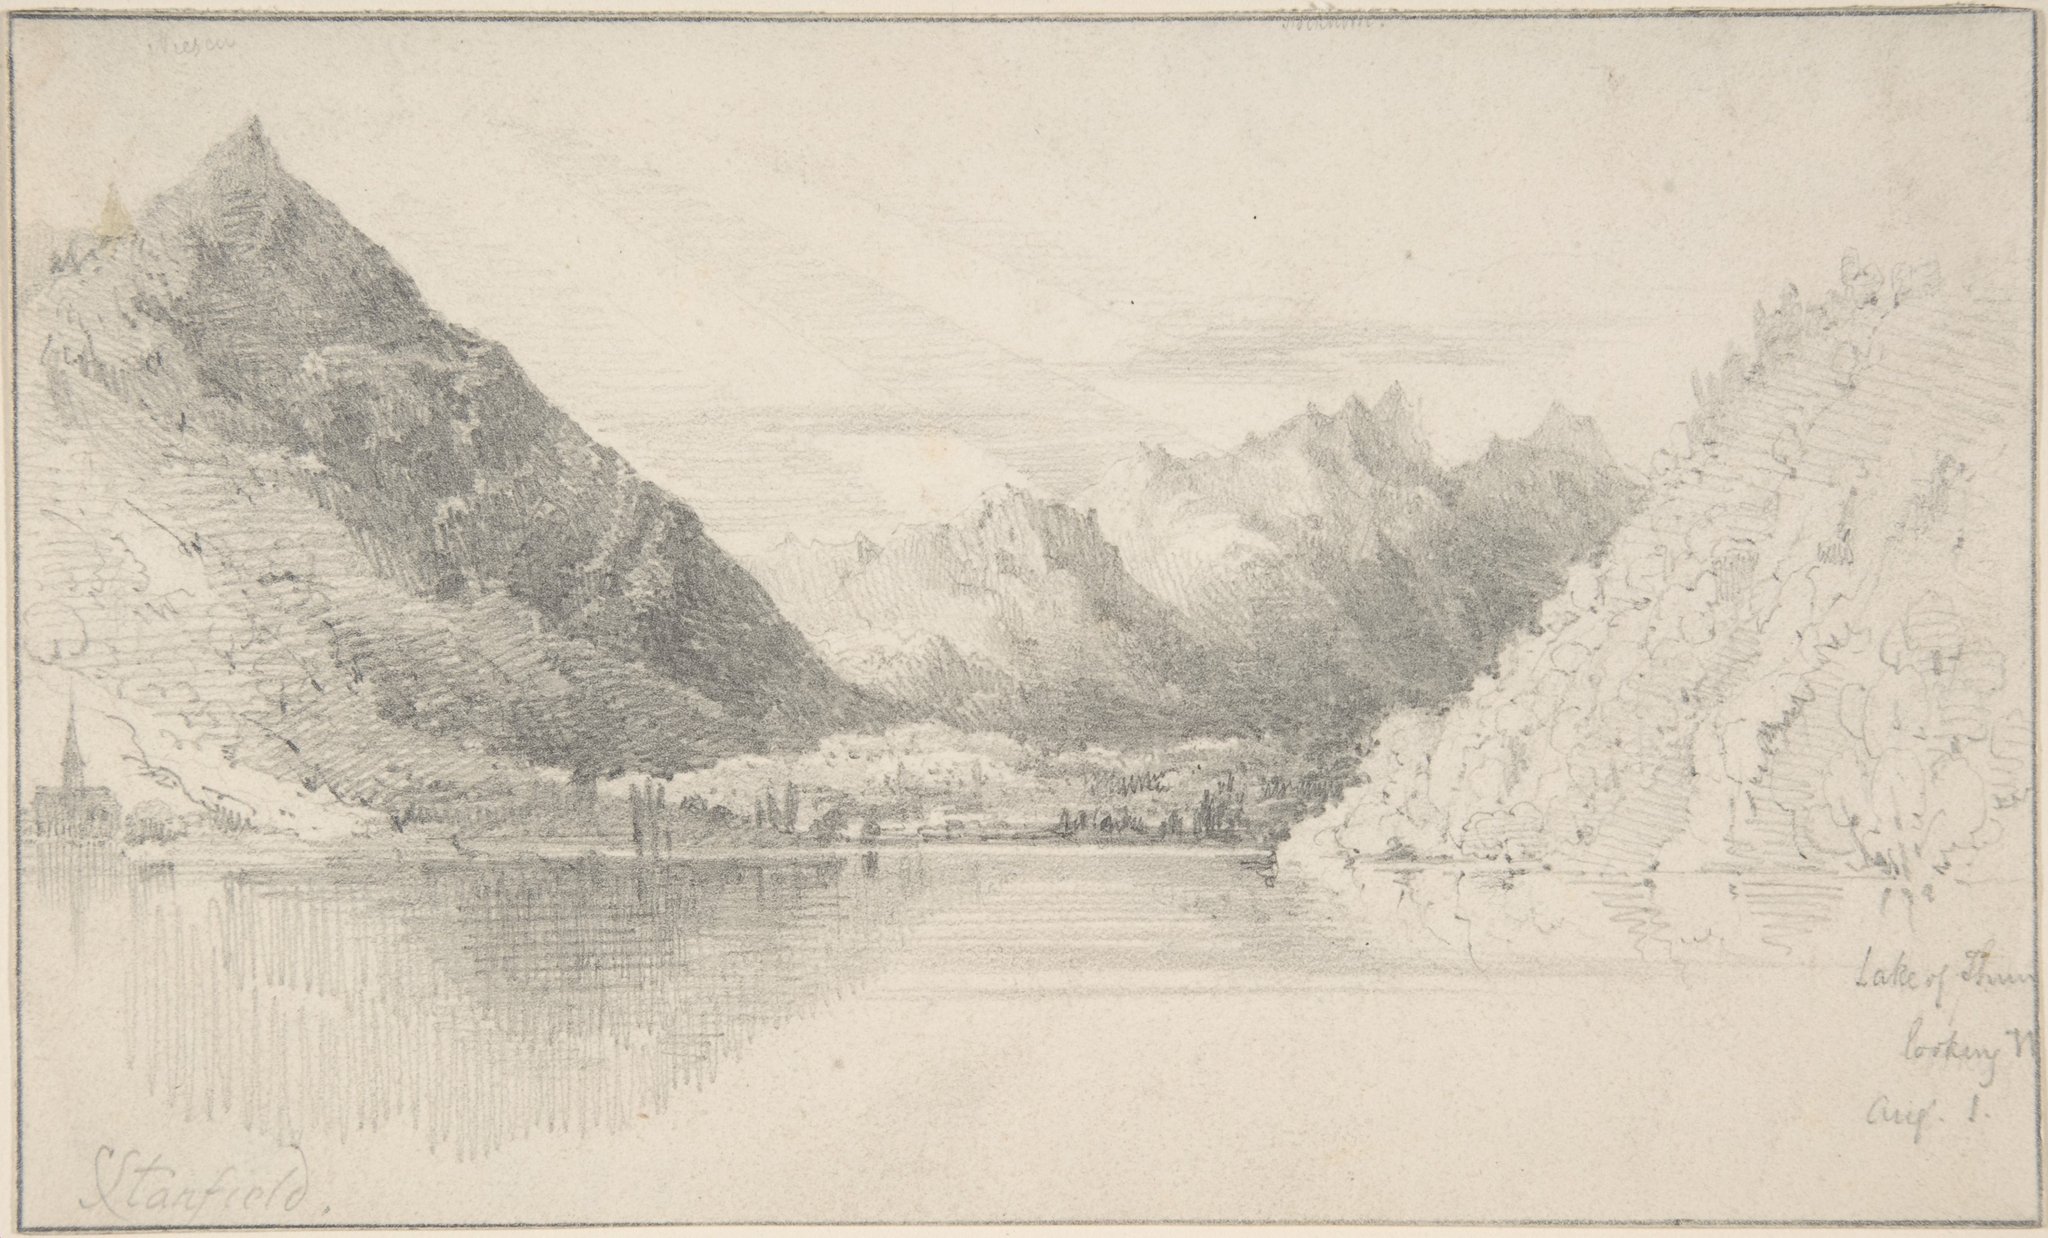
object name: drawing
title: Lake of Thun looking North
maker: clarkson stanfield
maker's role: artist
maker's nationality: british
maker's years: 1793-1867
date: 1820-1867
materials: graphite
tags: lakes,mountains